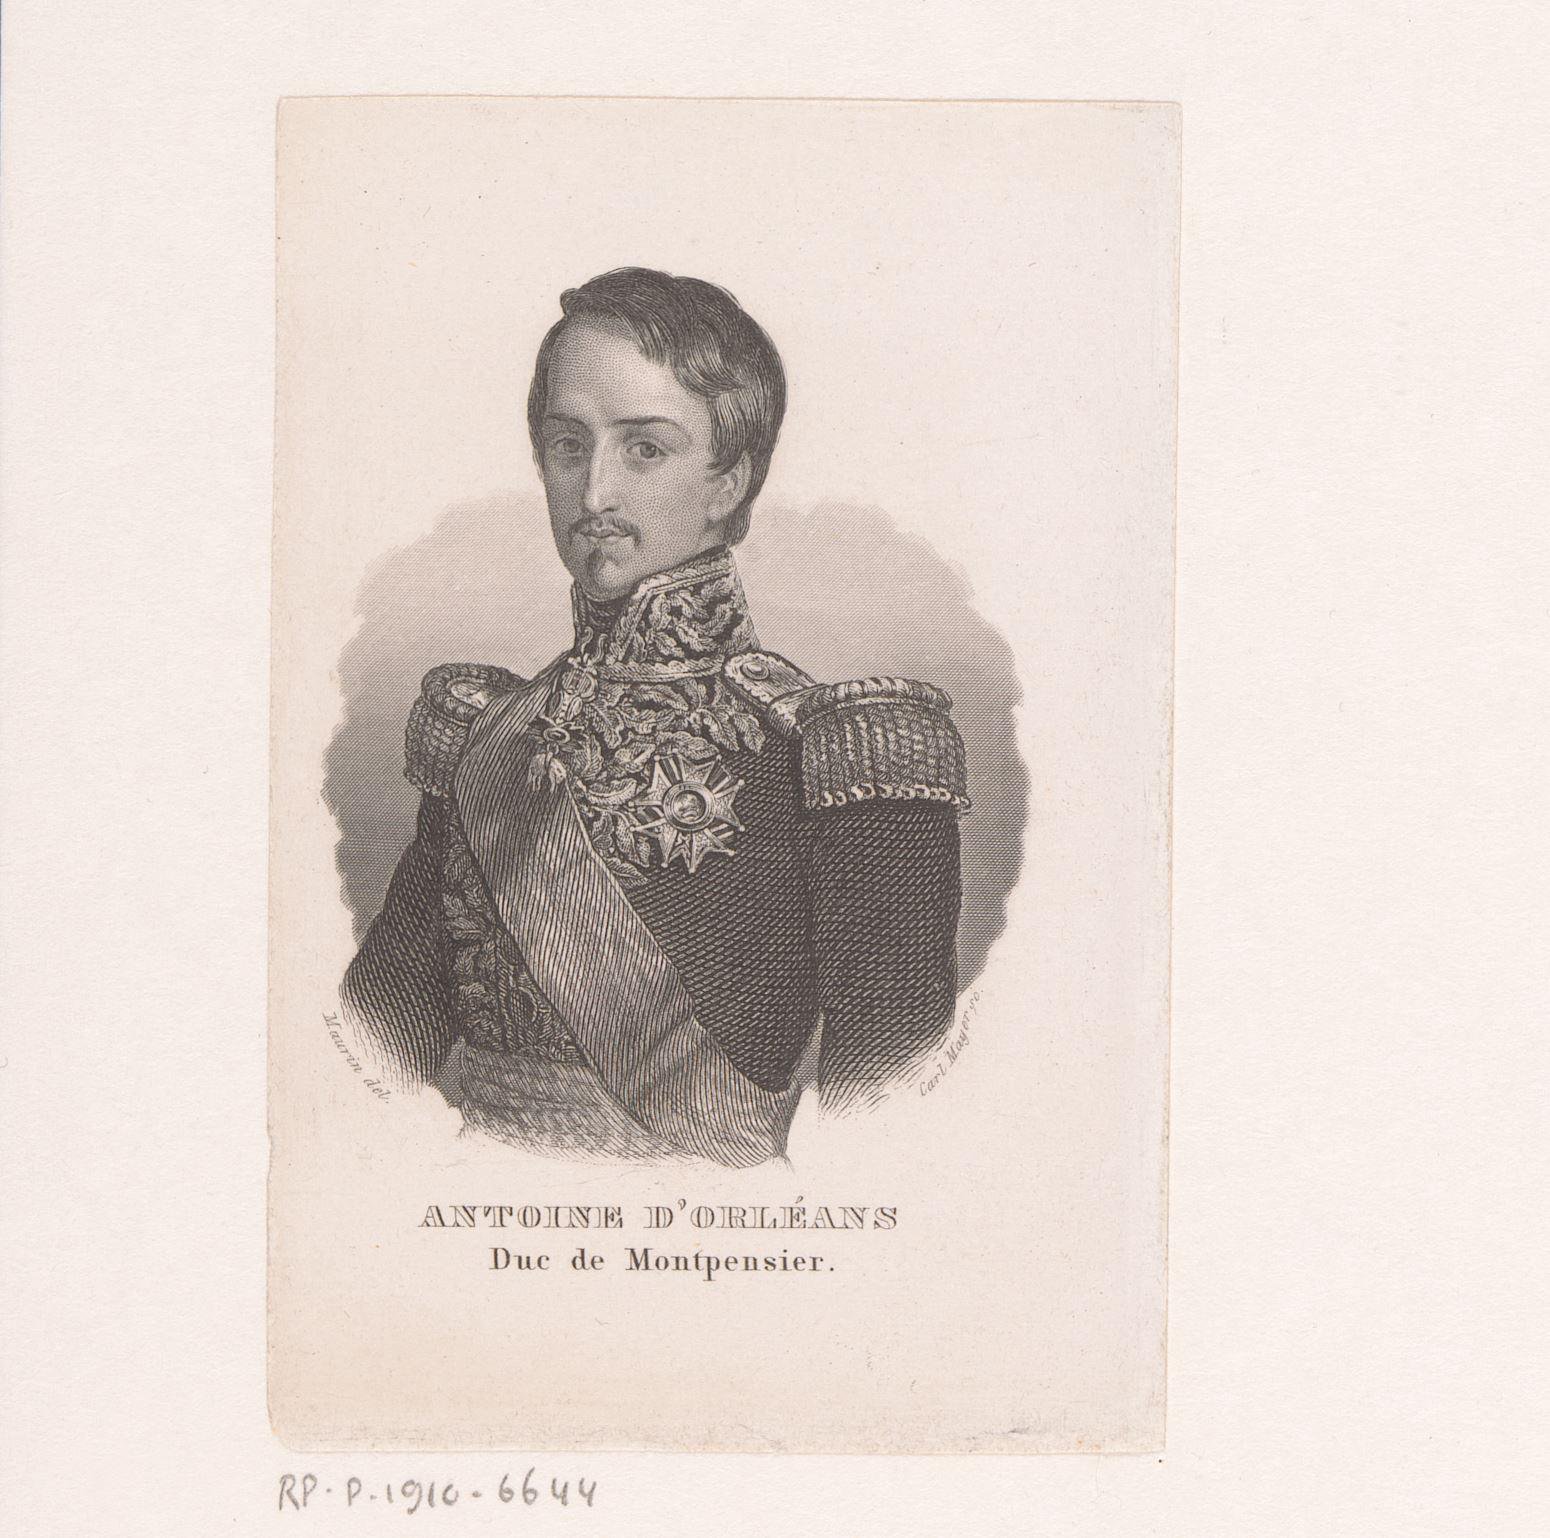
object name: print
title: Portret van Antoine d'Orléans, hertog van Montpensier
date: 1824-1868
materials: paper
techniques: engraving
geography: nuremberg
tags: historical persons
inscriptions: collector's mark: Lugt 2228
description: Vermoedelijk afkomstig uit: Almanach de Gotha.